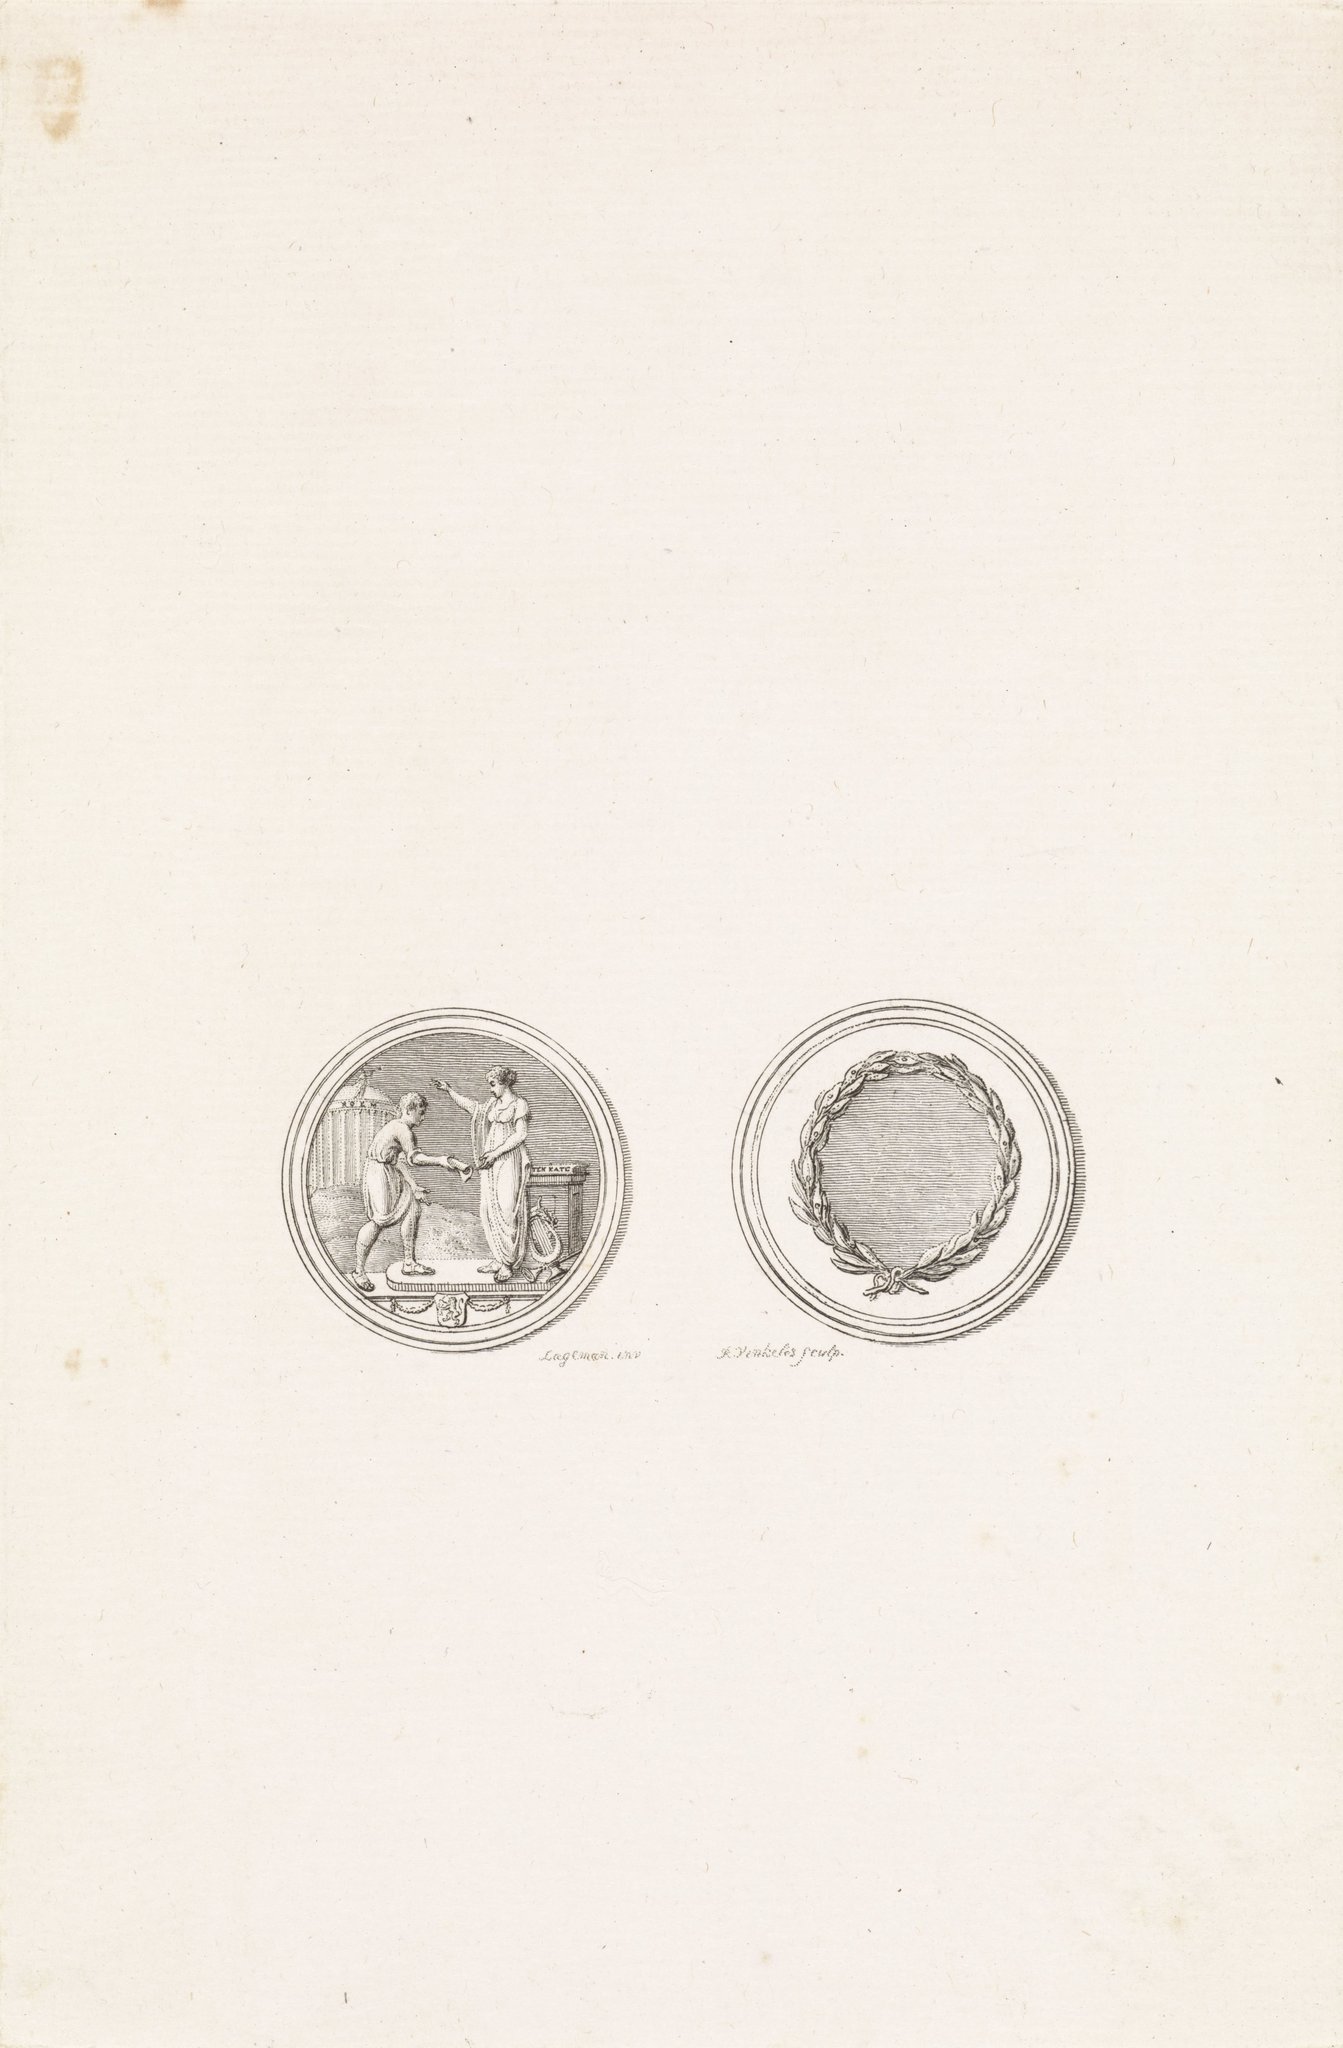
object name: print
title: Penning met op de achterzijde een lauwerkrans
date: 1751-1816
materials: paper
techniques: engraving, etching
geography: amsterdam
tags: trees: laurel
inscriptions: collector's mark: Lugt 240